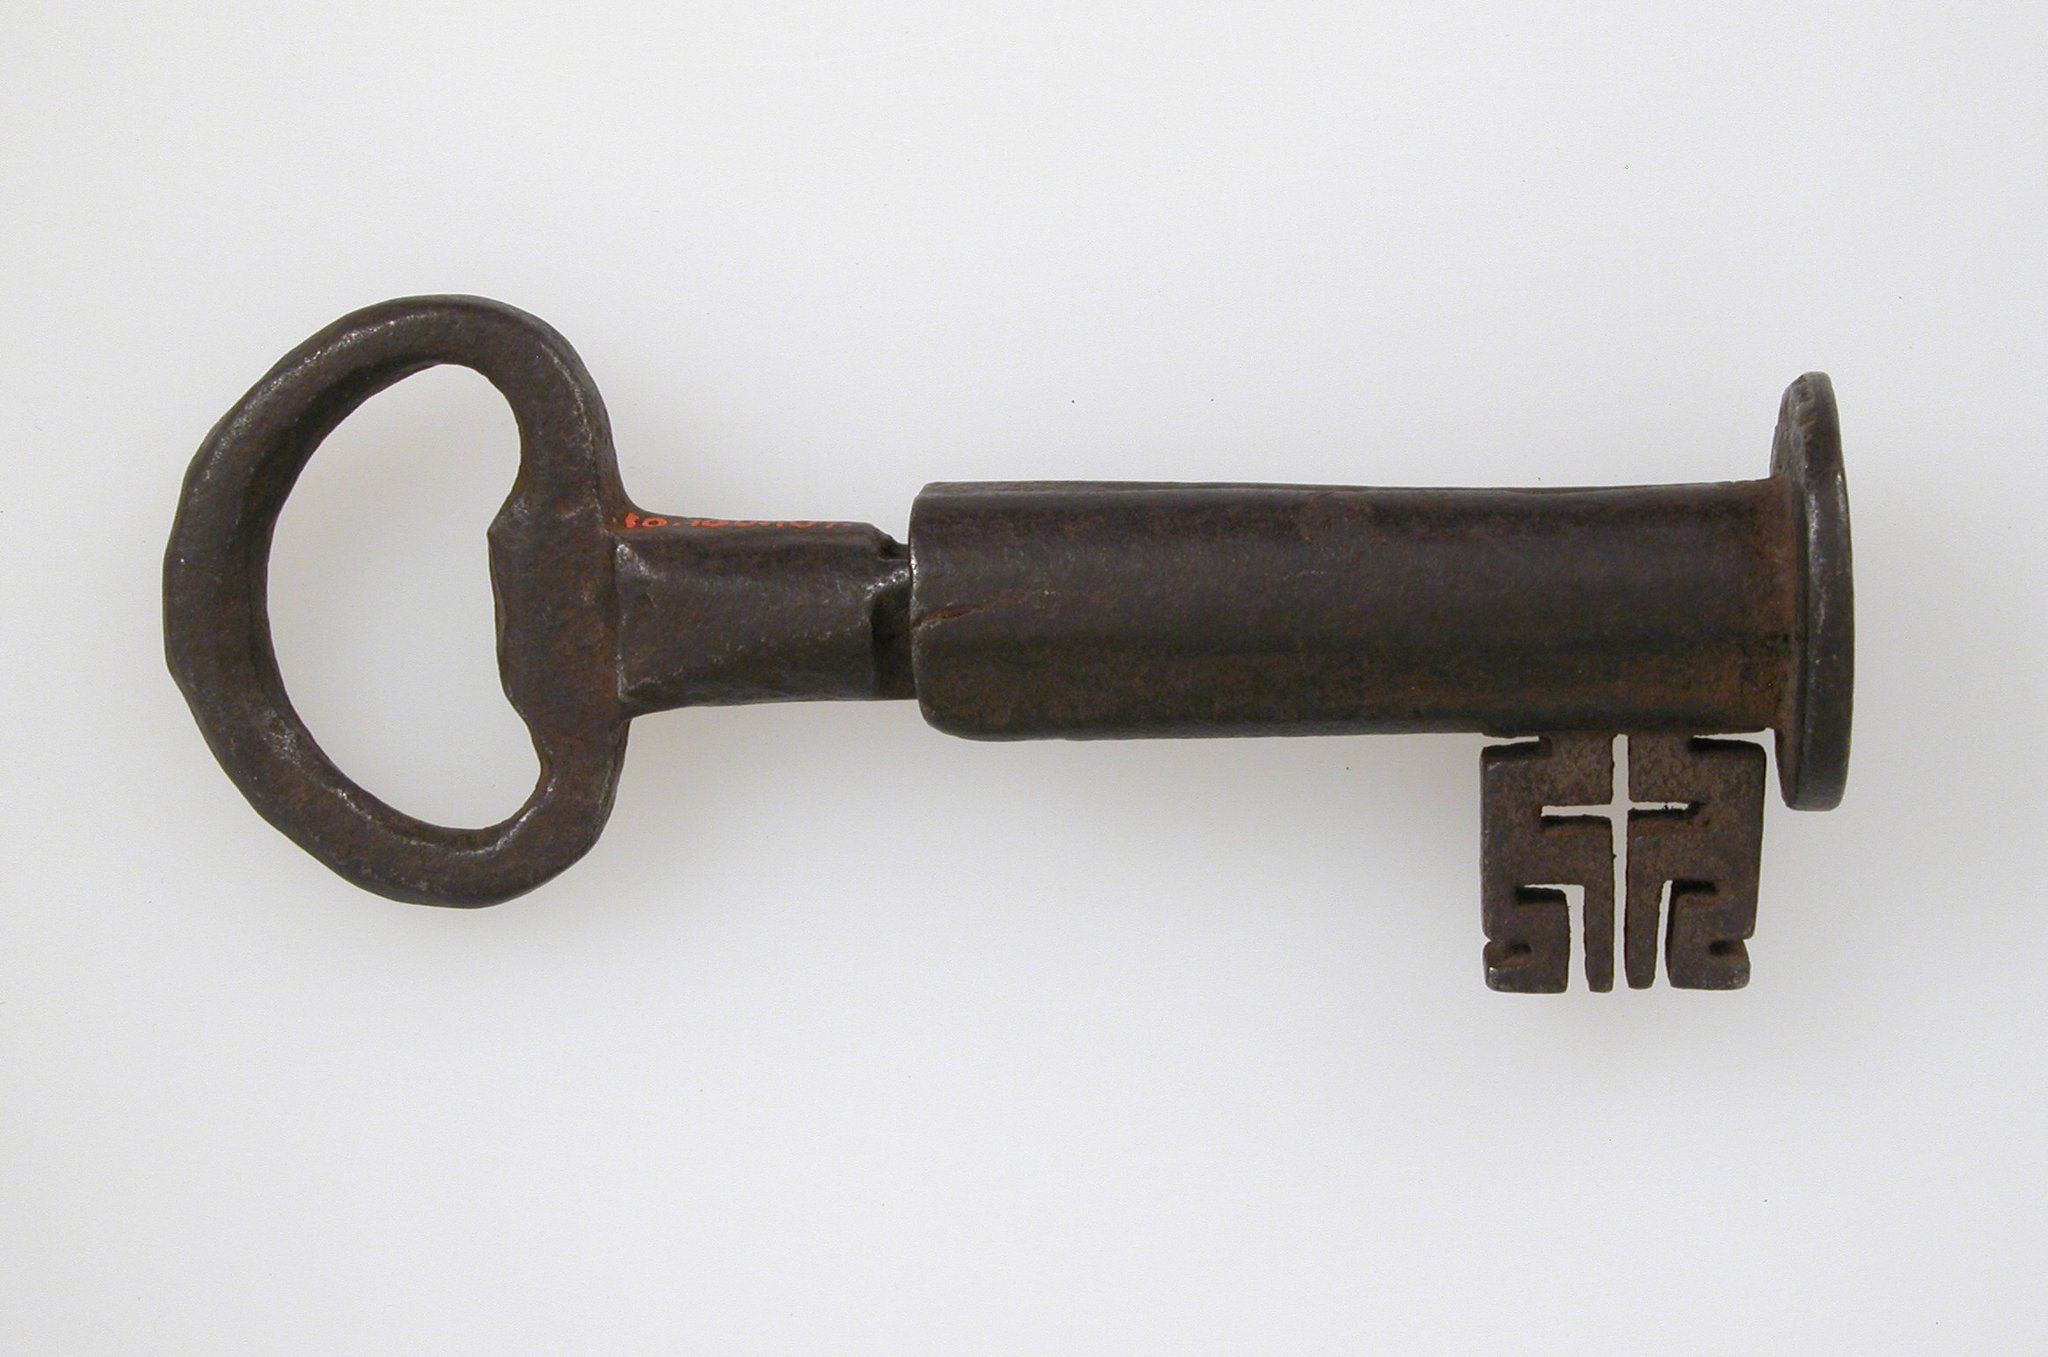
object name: key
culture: german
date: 1401-1500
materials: iron